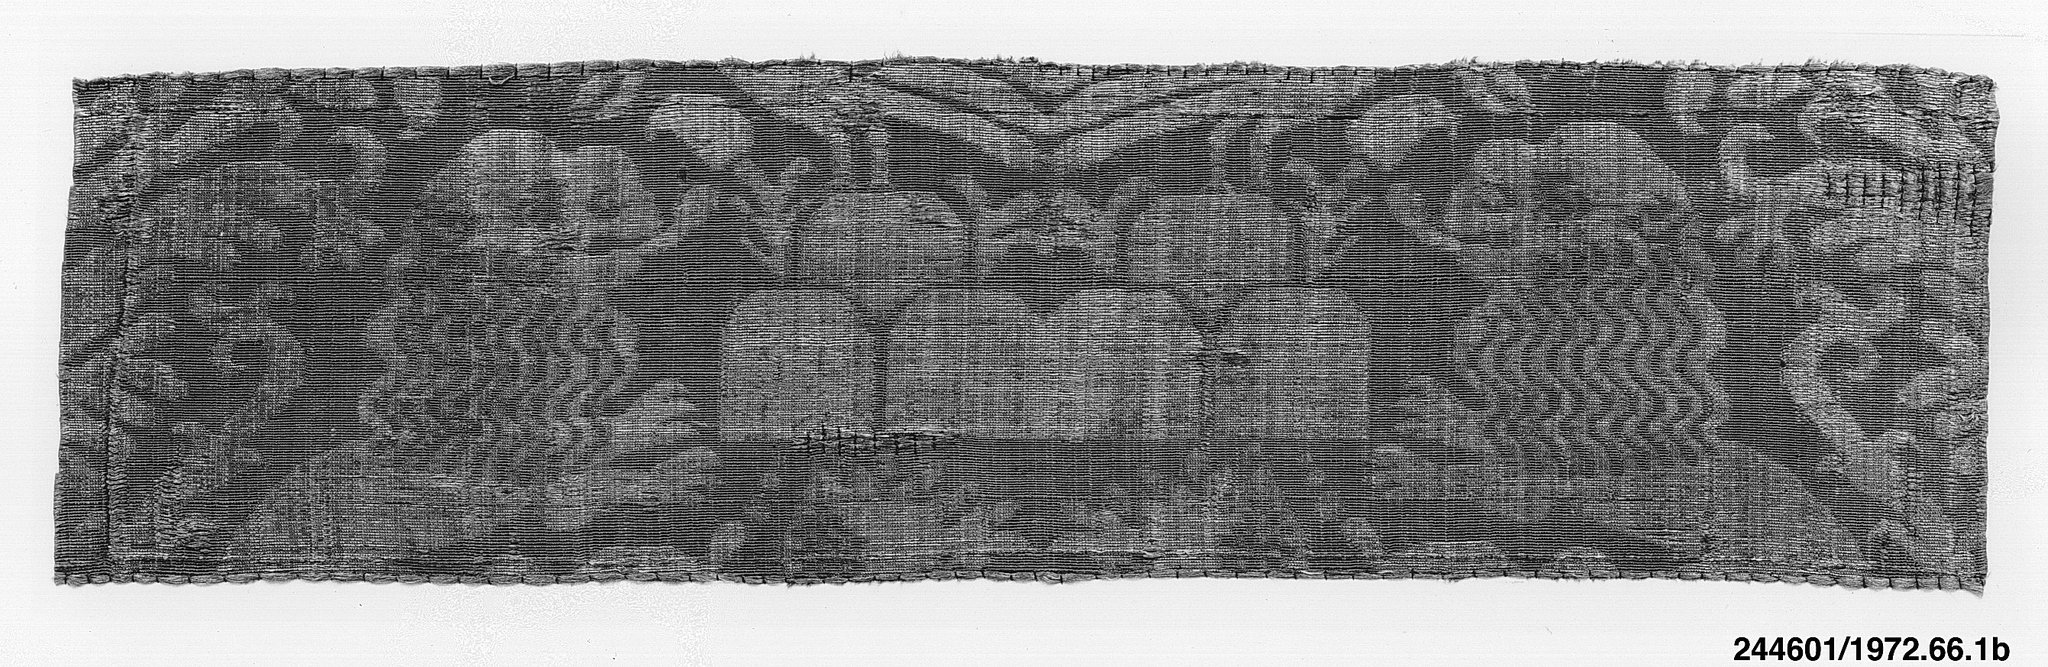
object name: piece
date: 1501-1600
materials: silk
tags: lions